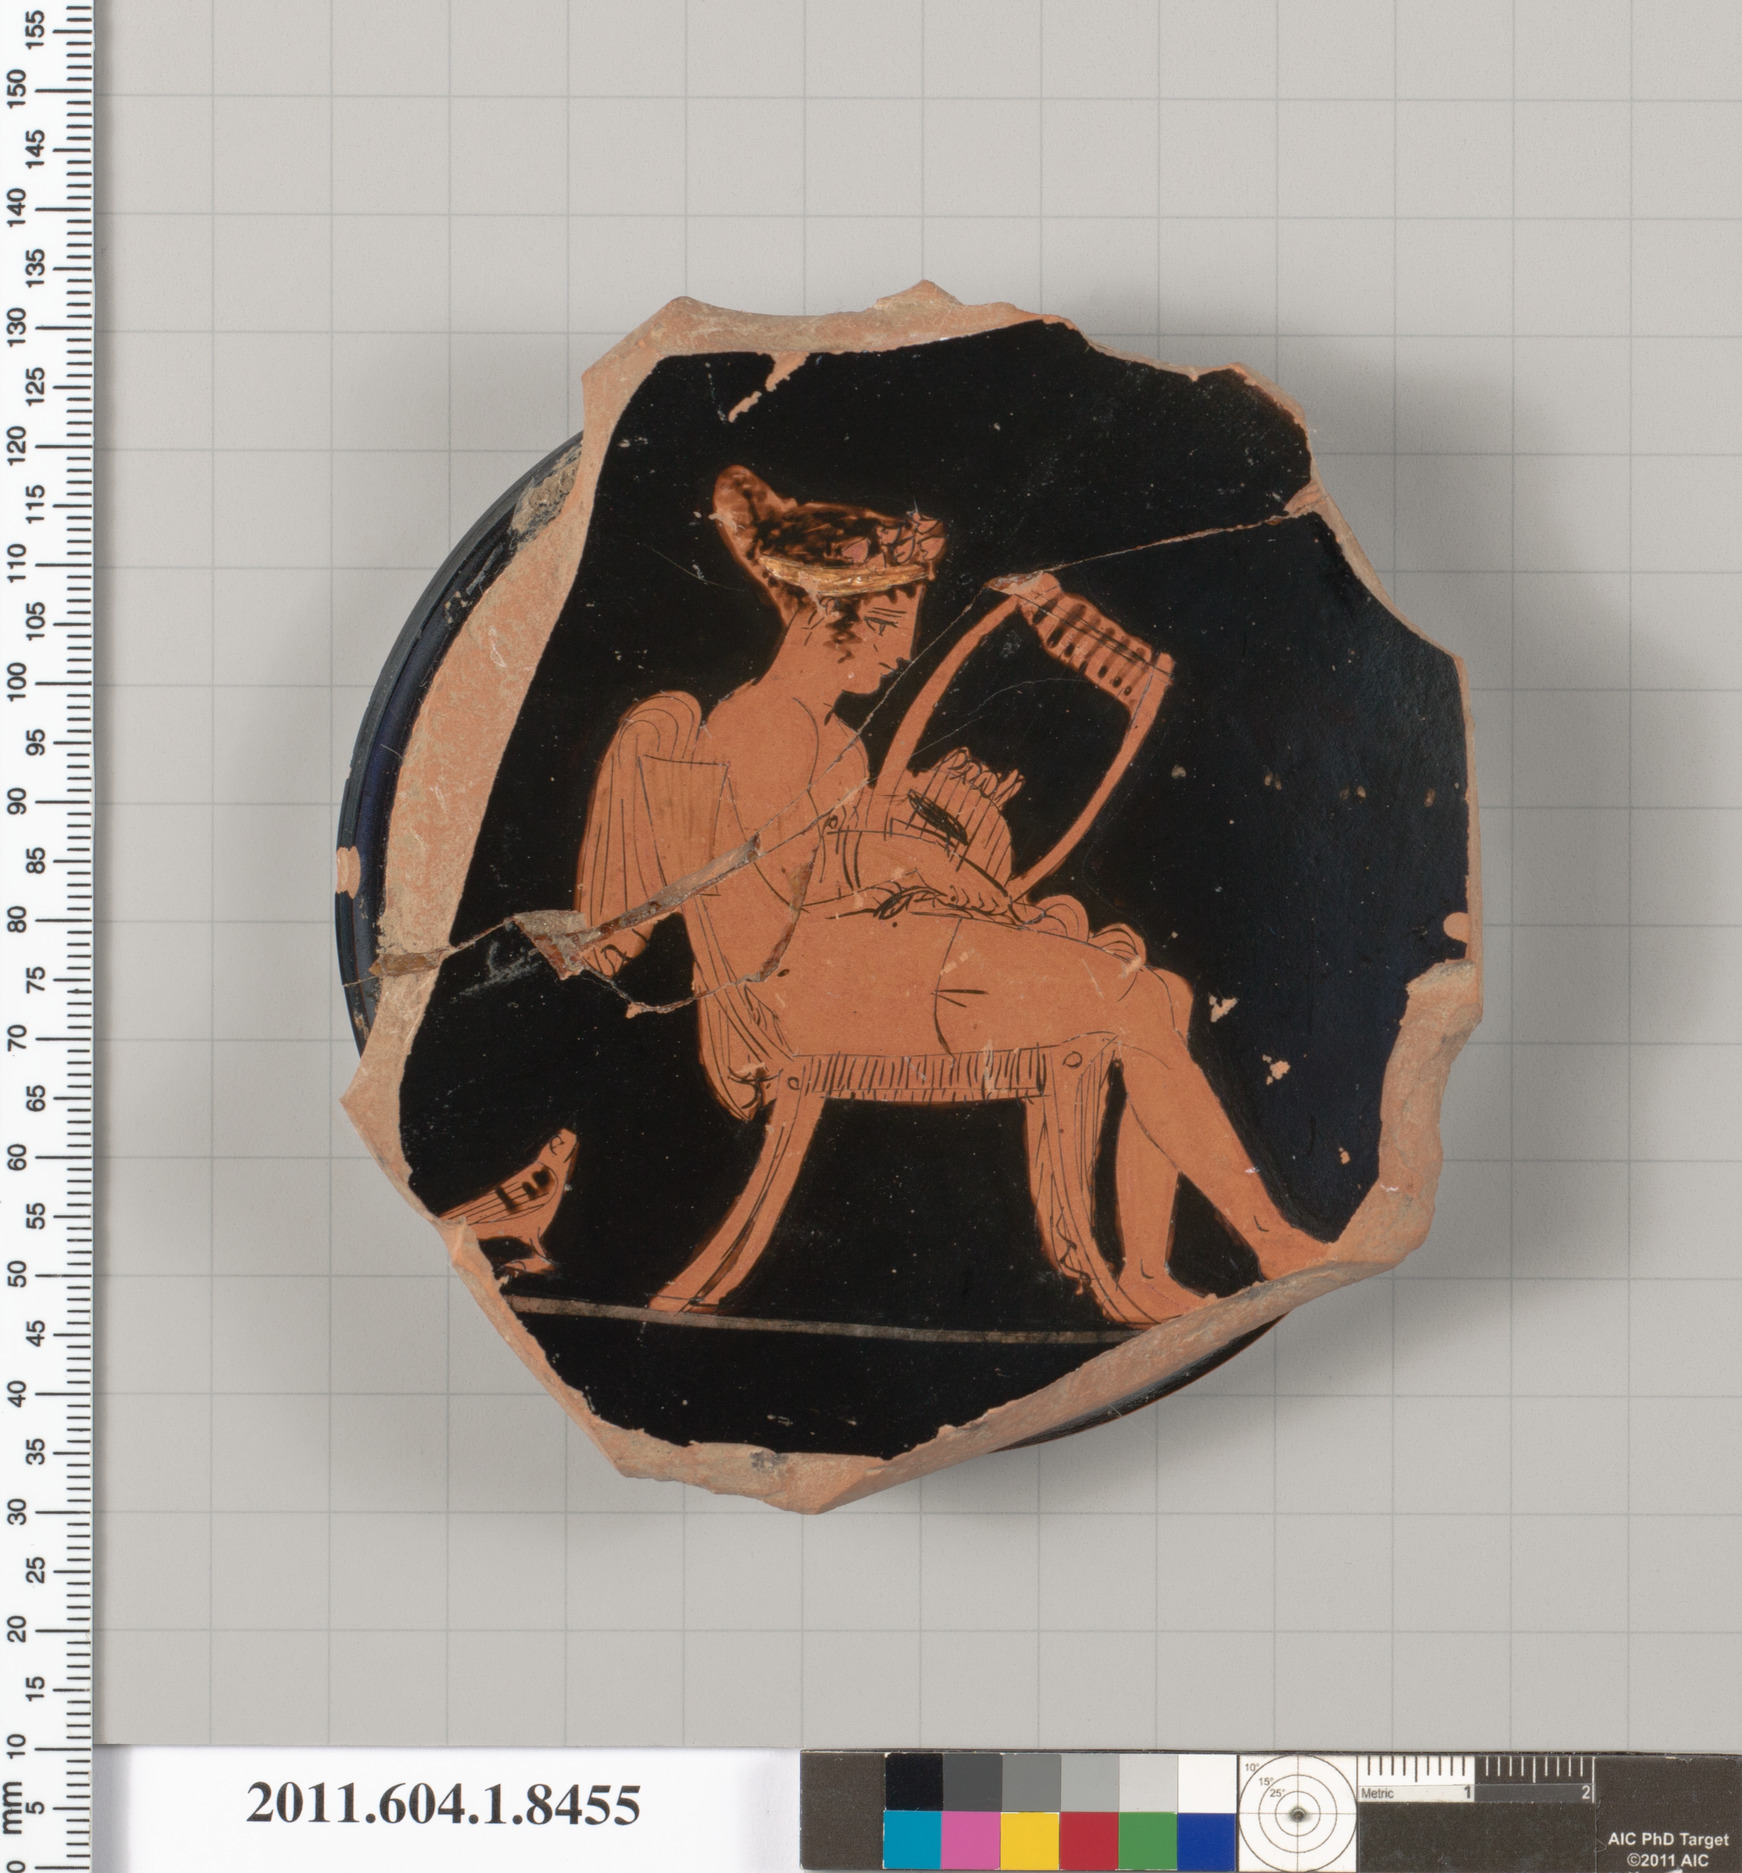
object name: kylix fragment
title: Terracotta fragment of a stemless kylix (drinking cup)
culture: greek, attic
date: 467-435 BCE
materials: terracotta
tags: women,lyres